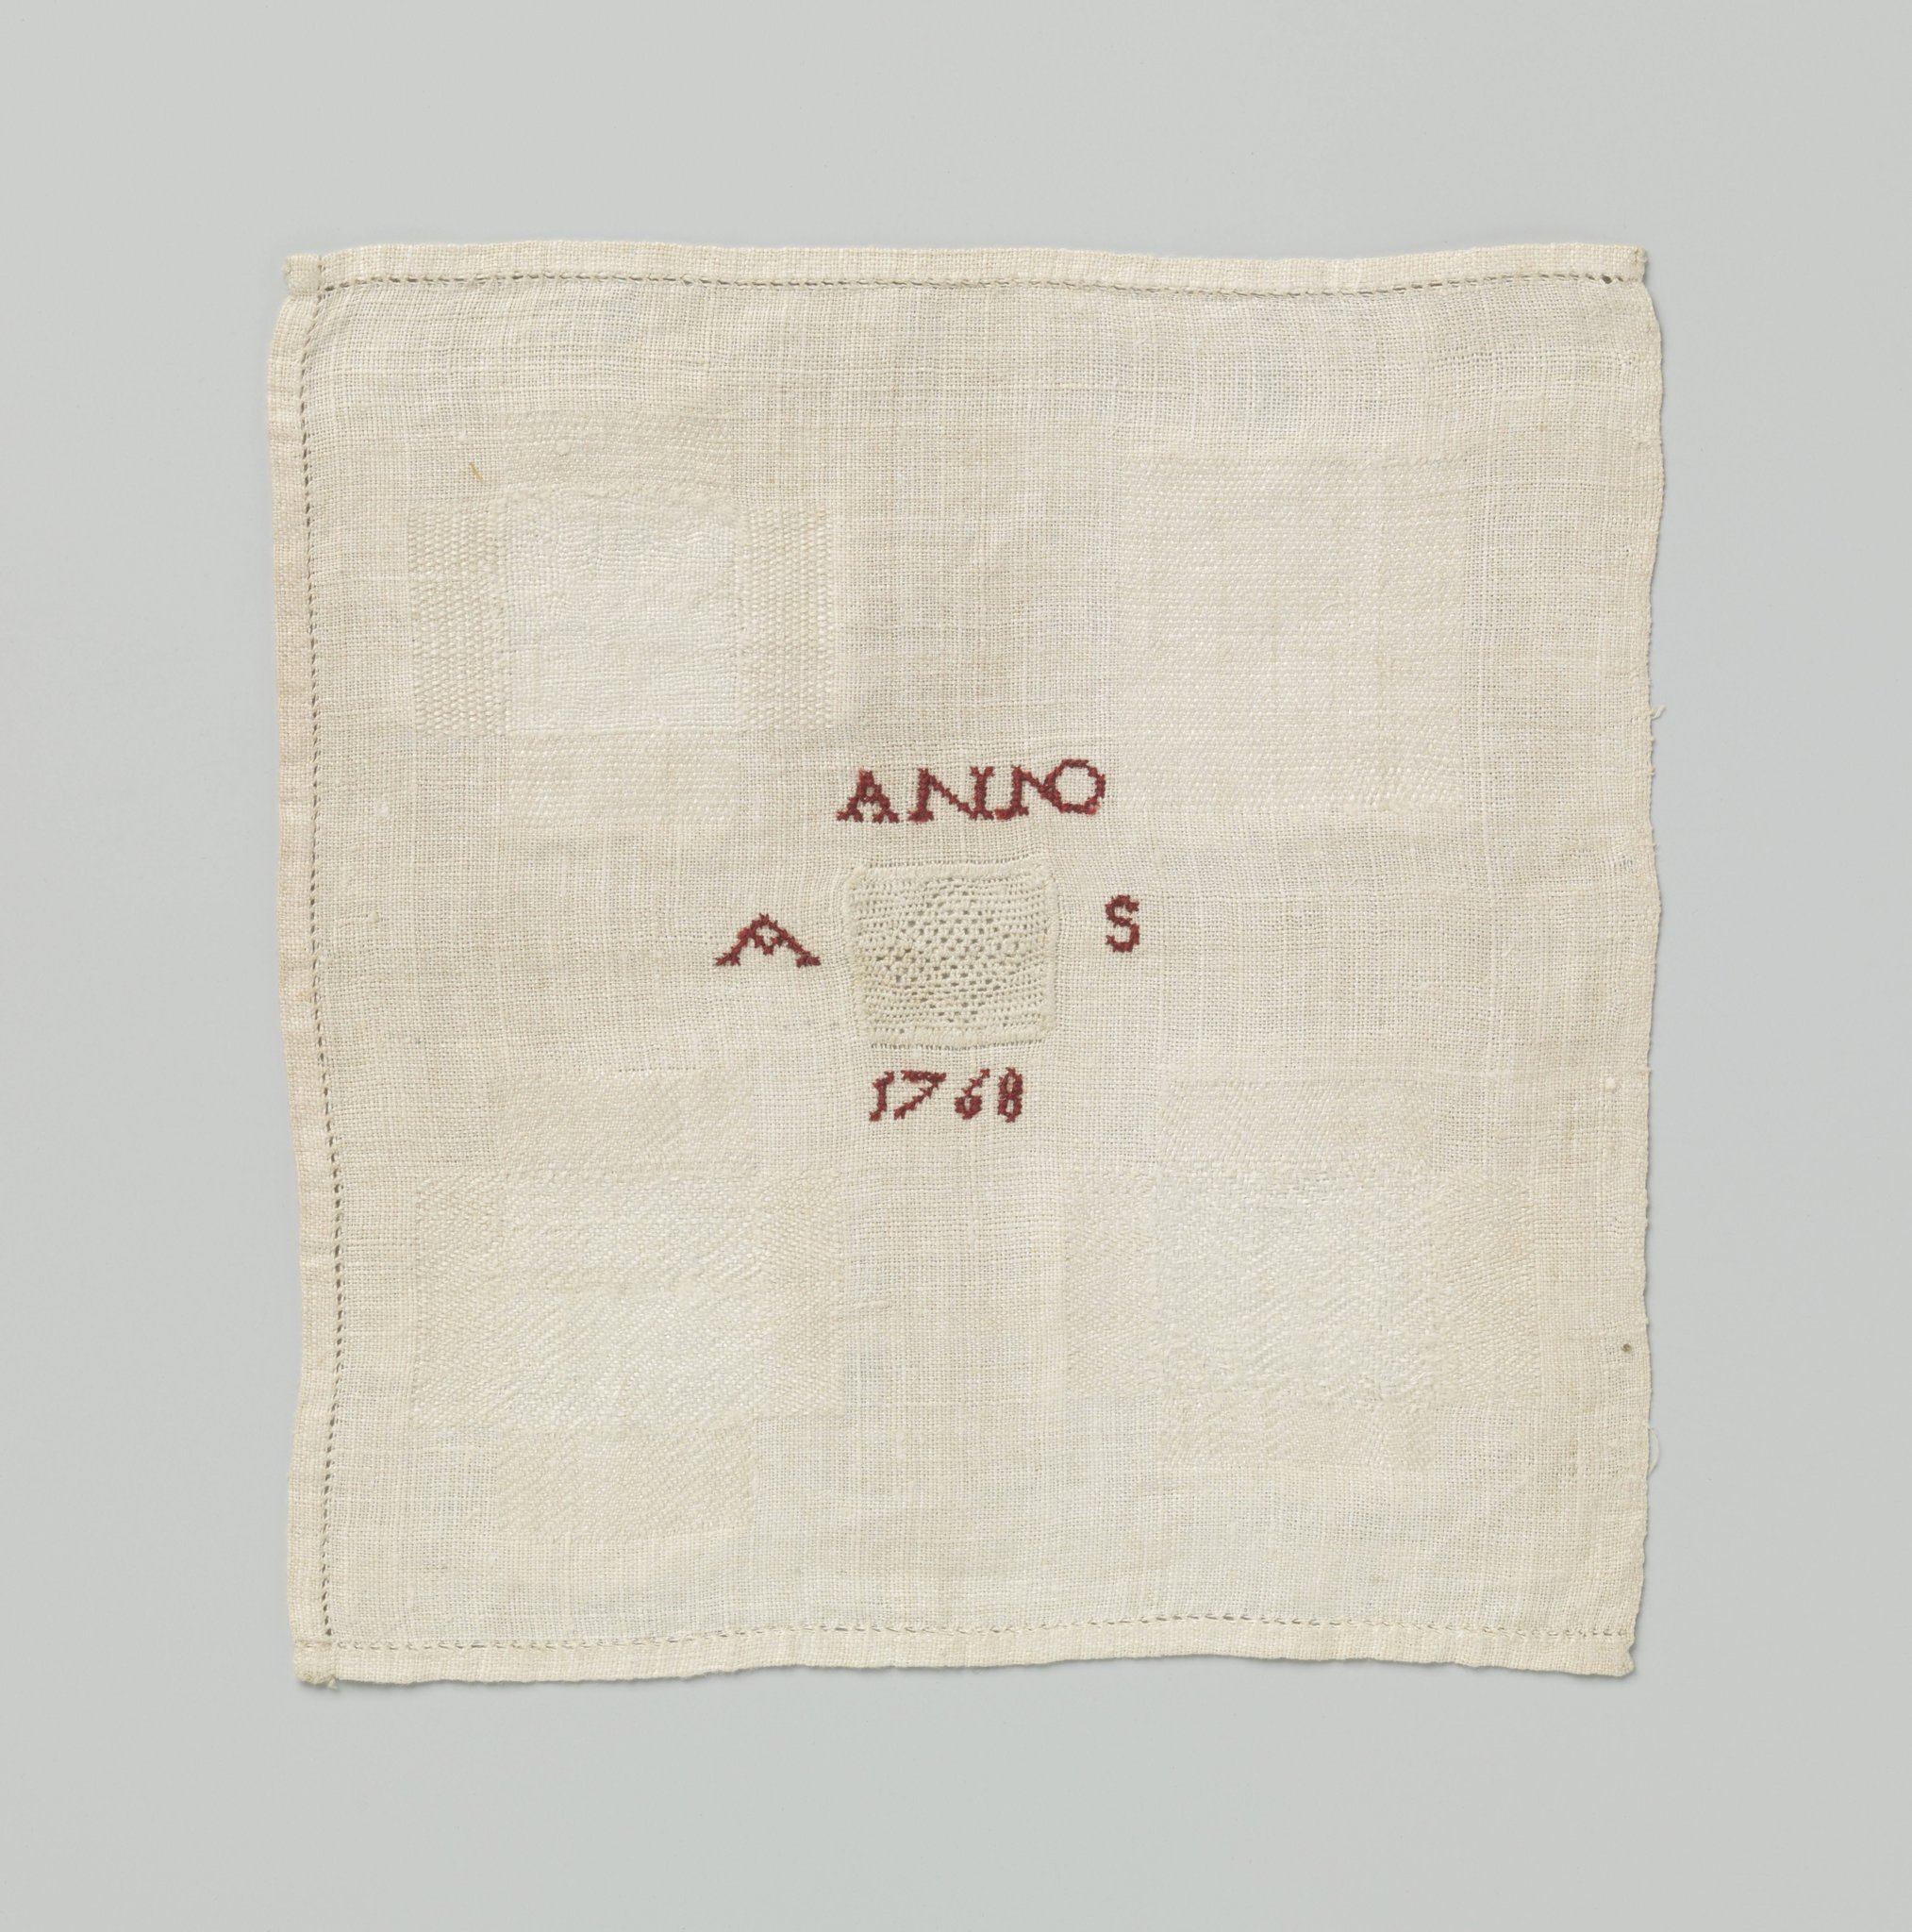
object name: stoplap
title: Stoplap van naturelkleurig linnen en roodbruine zijde op linnen.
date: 1768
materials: linen, silk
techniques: embroidered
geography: netherlands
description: Stoplap van linnen en zijde op linnen. Het borduurwerk heeft de datering ANNO 1768.